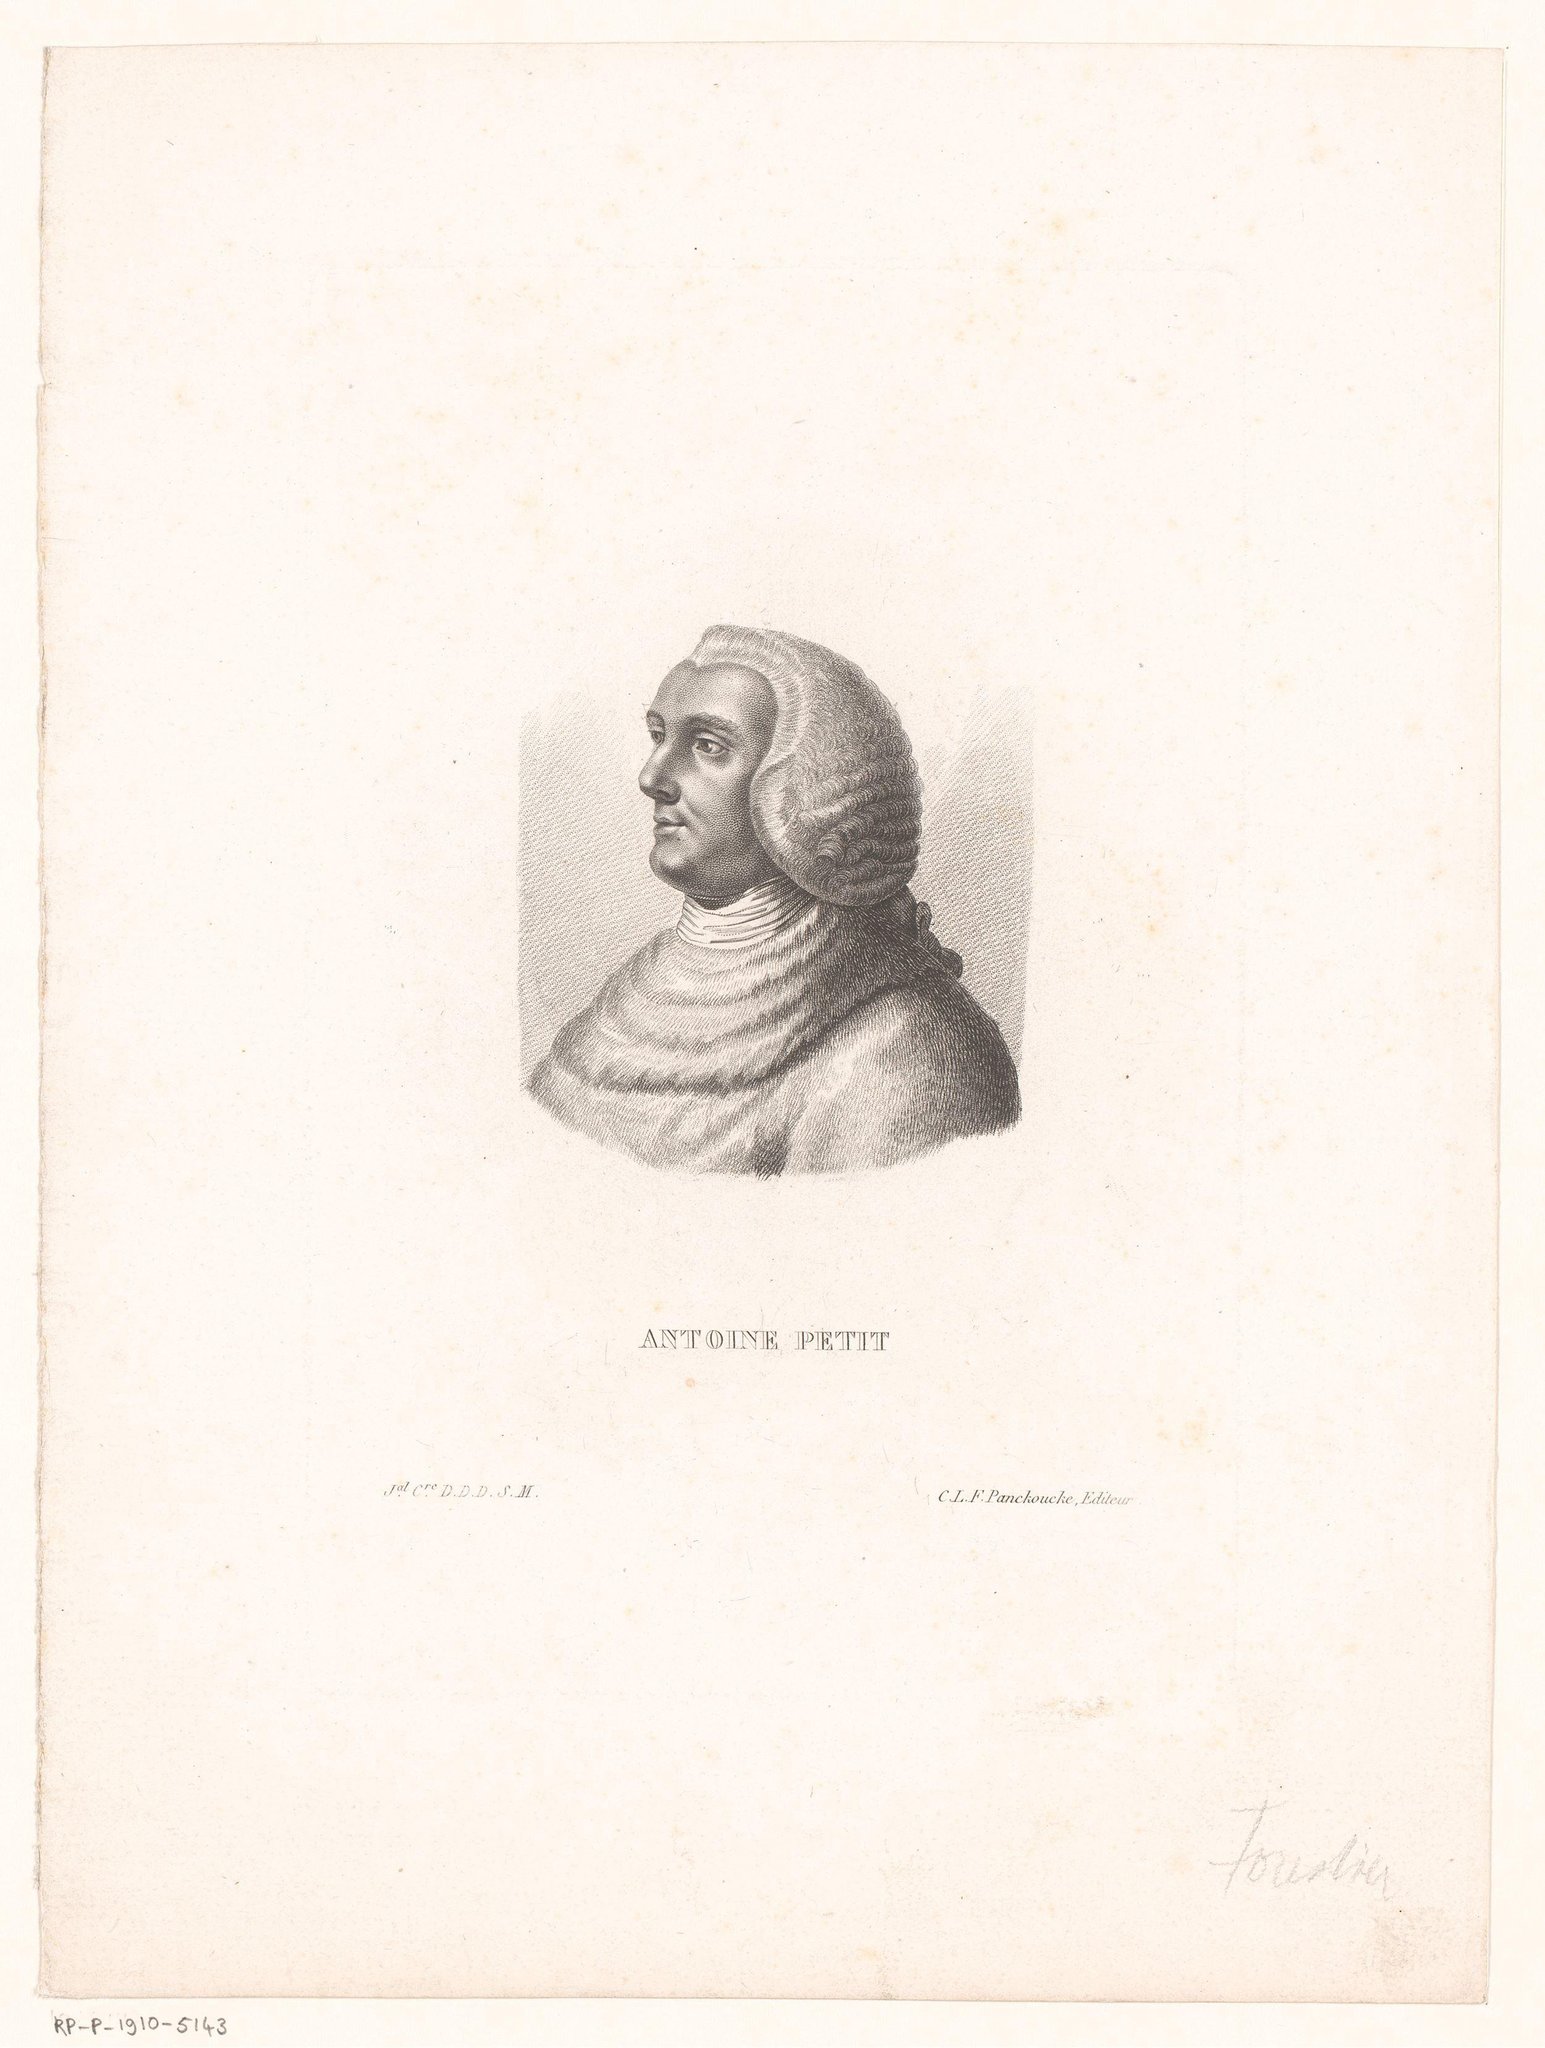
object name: print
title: Portret van Antoine Petit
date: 1818-1832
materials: paper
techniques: engraving, roulette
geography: france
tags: historical persons, physician, doctor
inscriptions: collector's mark: Lugt 2228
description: Prent uit: Journal complémentaire du Dictionnaire des sciences médicales. Parijs: Panckoucke, Charles Louis Fleury, 1818-1832.